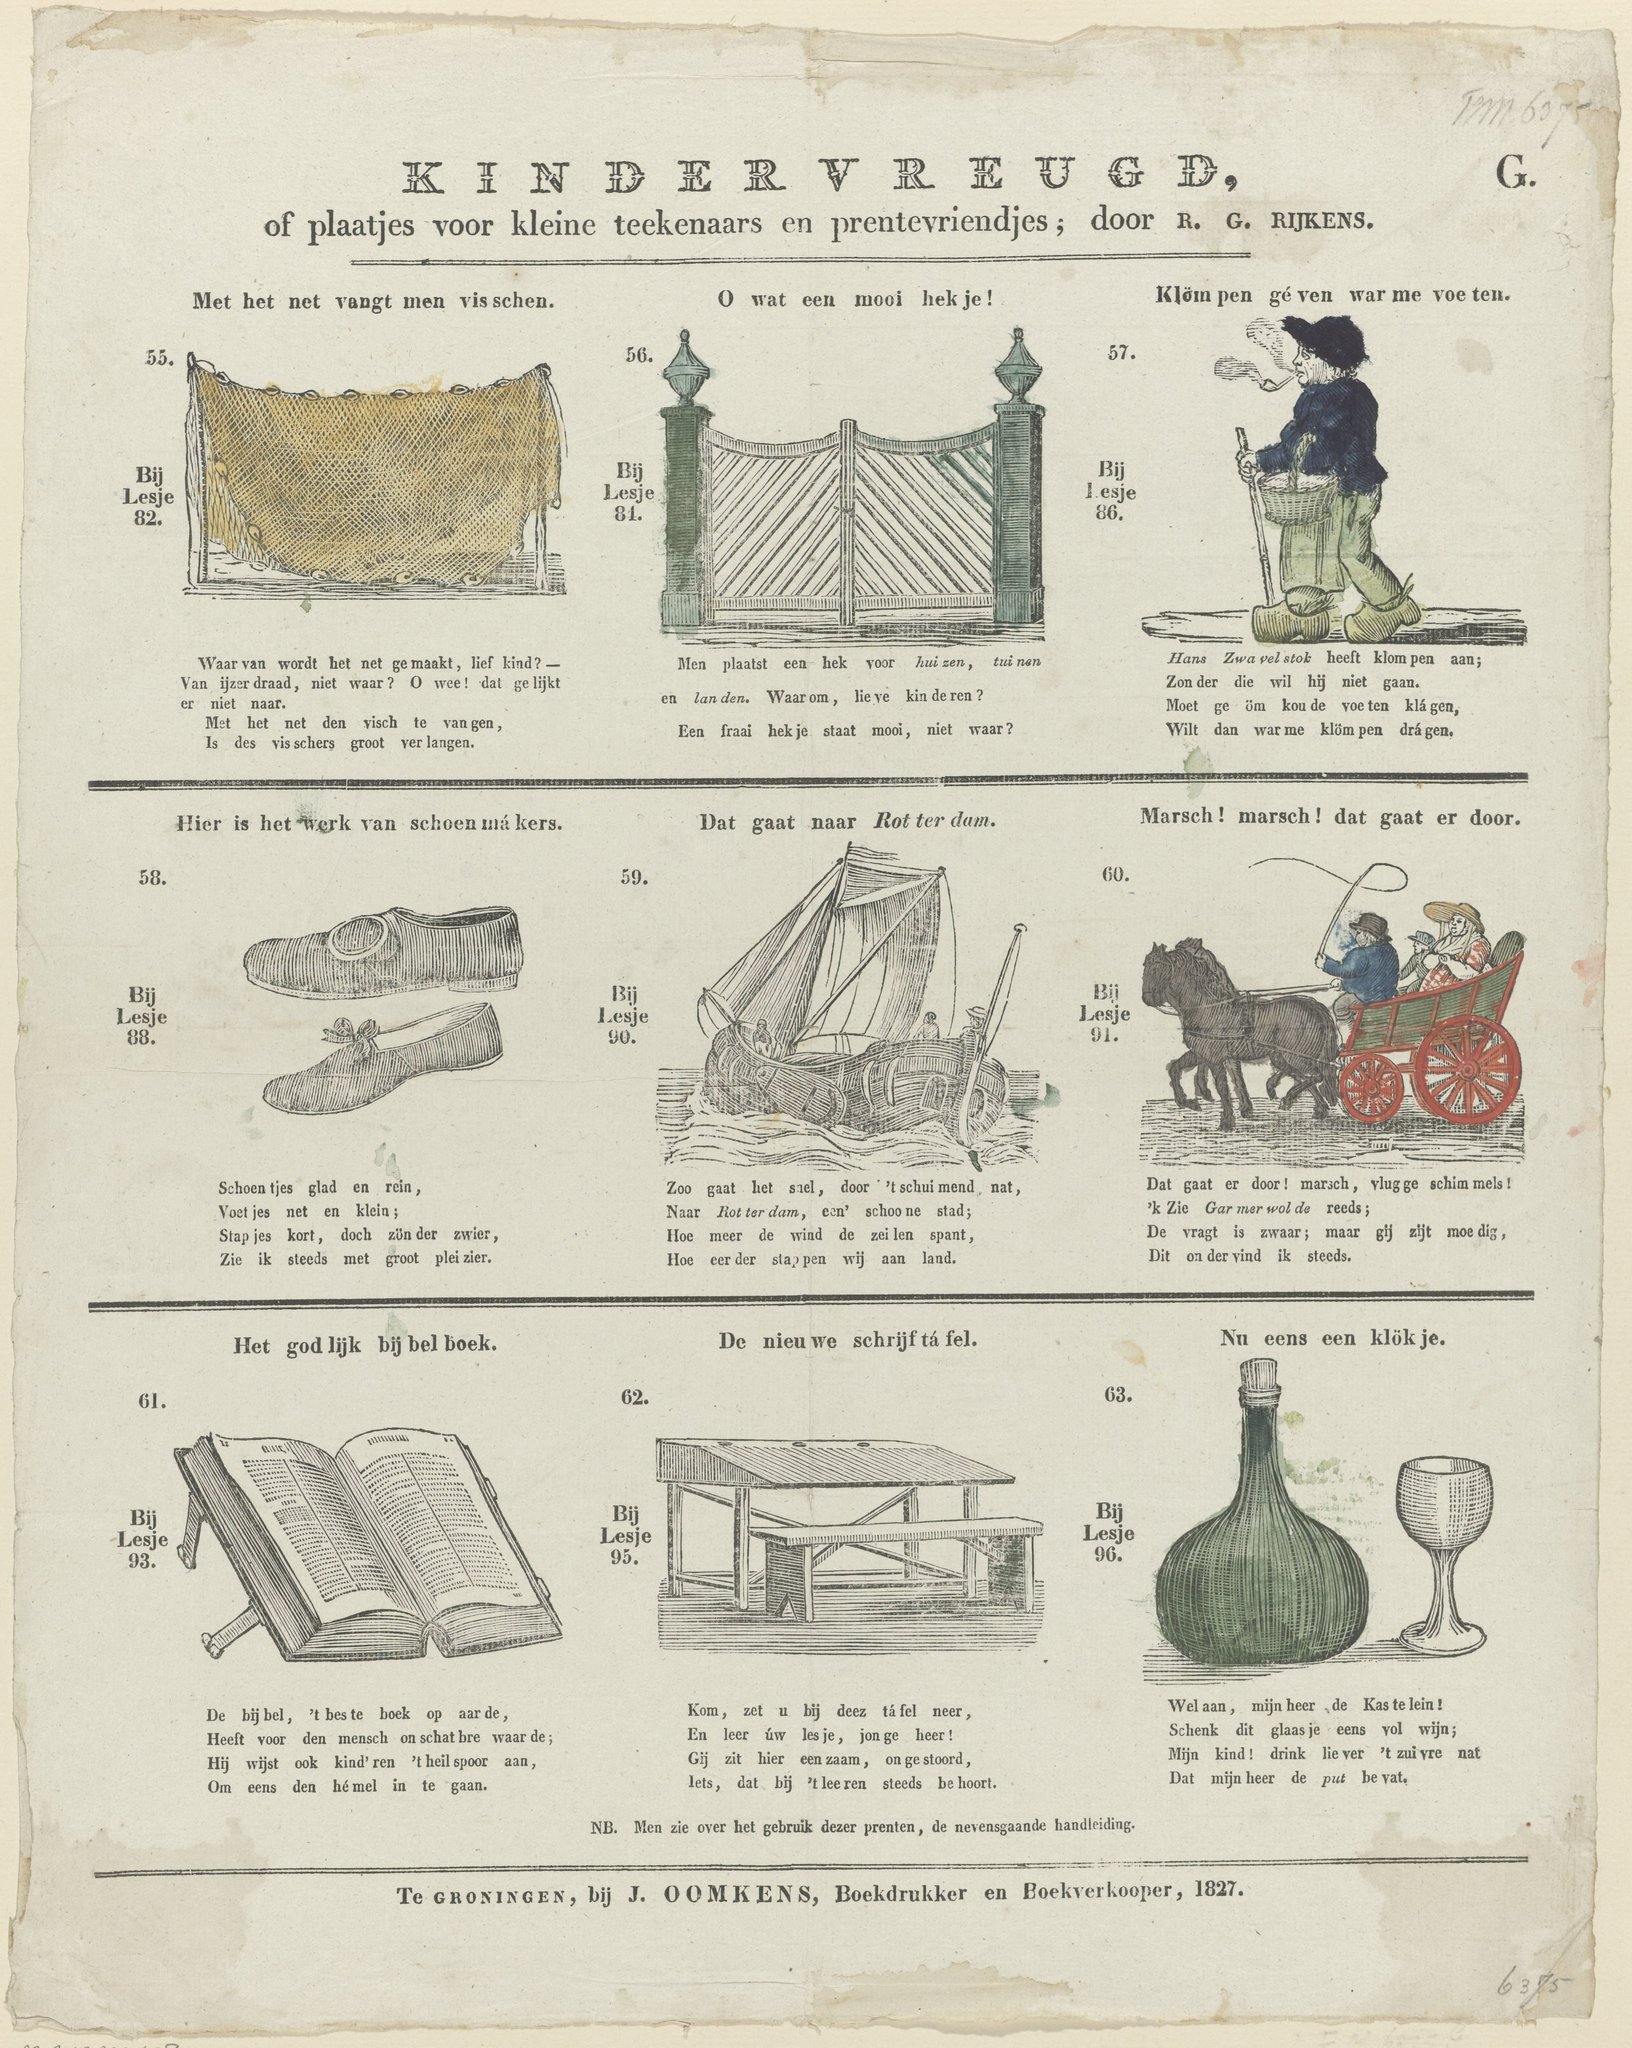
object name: popular print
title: Met het net vangt men visschen (...)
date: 1827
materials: paper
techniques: colour, letterpress printing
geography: groningen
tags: writing-table, writing-desk, fishing net, fence, wall, paling, shoes, sandals, education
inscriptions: date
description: Blad met 9 illustraties (genummerd 55-63) bij leesboekjes van R.G. Rijkens. Elk plaatje hoort bij een lesje uit de boekjes "Natuurlijke Lees-Leerwijze". Weergegeven zijn ondermeer een visnet, een hek, schoenen en een schrijftafel. Boven elke afbeelding een nummer en een titel en onder elke afbeelding een vierregelig vers. Links van elke afbeelding staat vermeld bij welke les het plaatje hoort. Gemerkt rechtsboven: G.